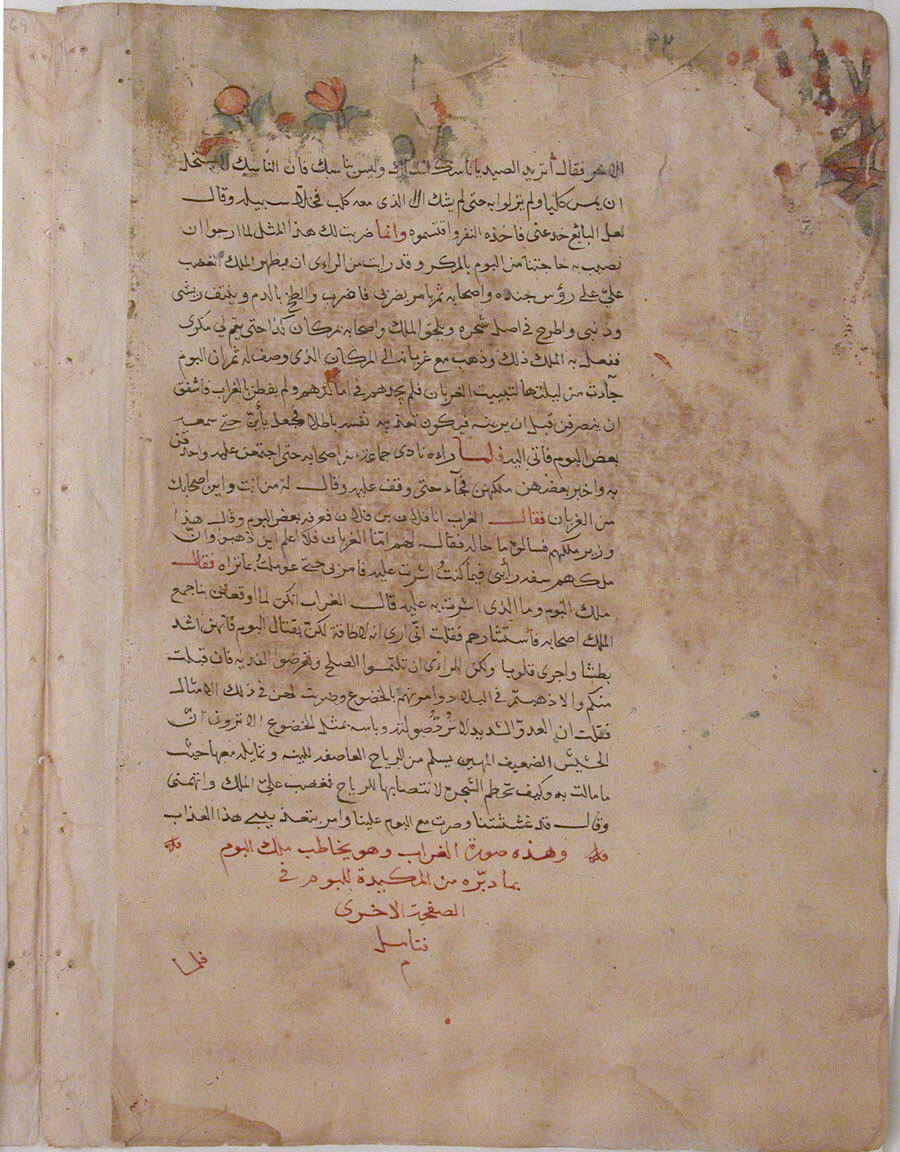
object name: folio from an illustrated manuscript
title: Page of Calligraphy from a Kalila wa Dimna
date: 1526-1550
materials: ink, paper, watercolor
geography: india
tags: arabic,calligraphy